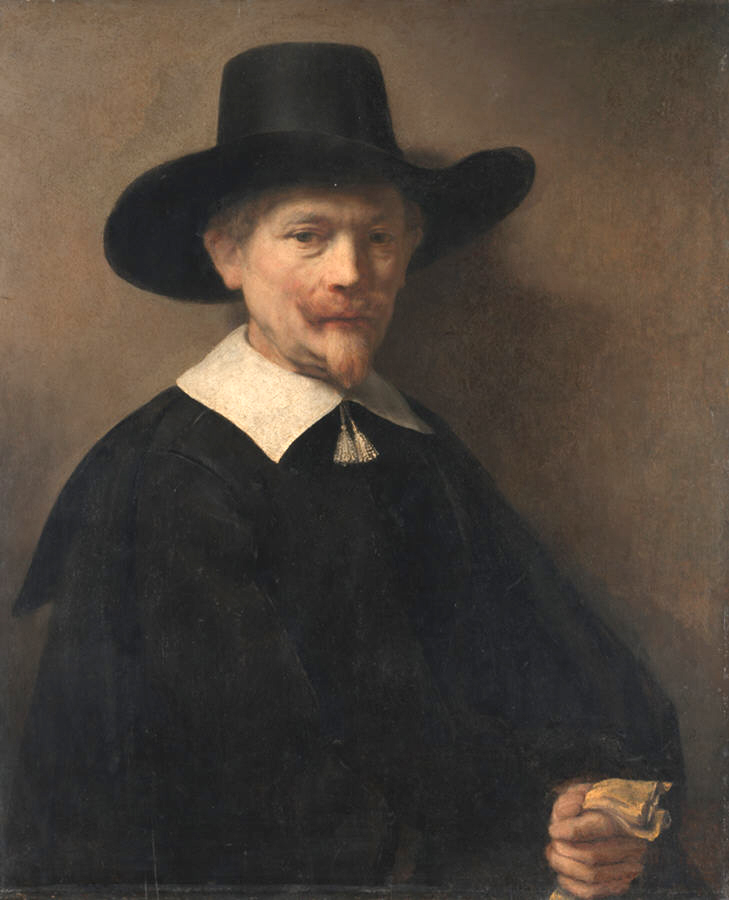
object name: painting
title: Portrait of a Man Holding Gloves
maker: rembrandt van rijn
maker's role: artist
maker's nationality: dutch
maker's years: 1606-1669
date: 1648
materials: oil, wood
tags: men,portraits